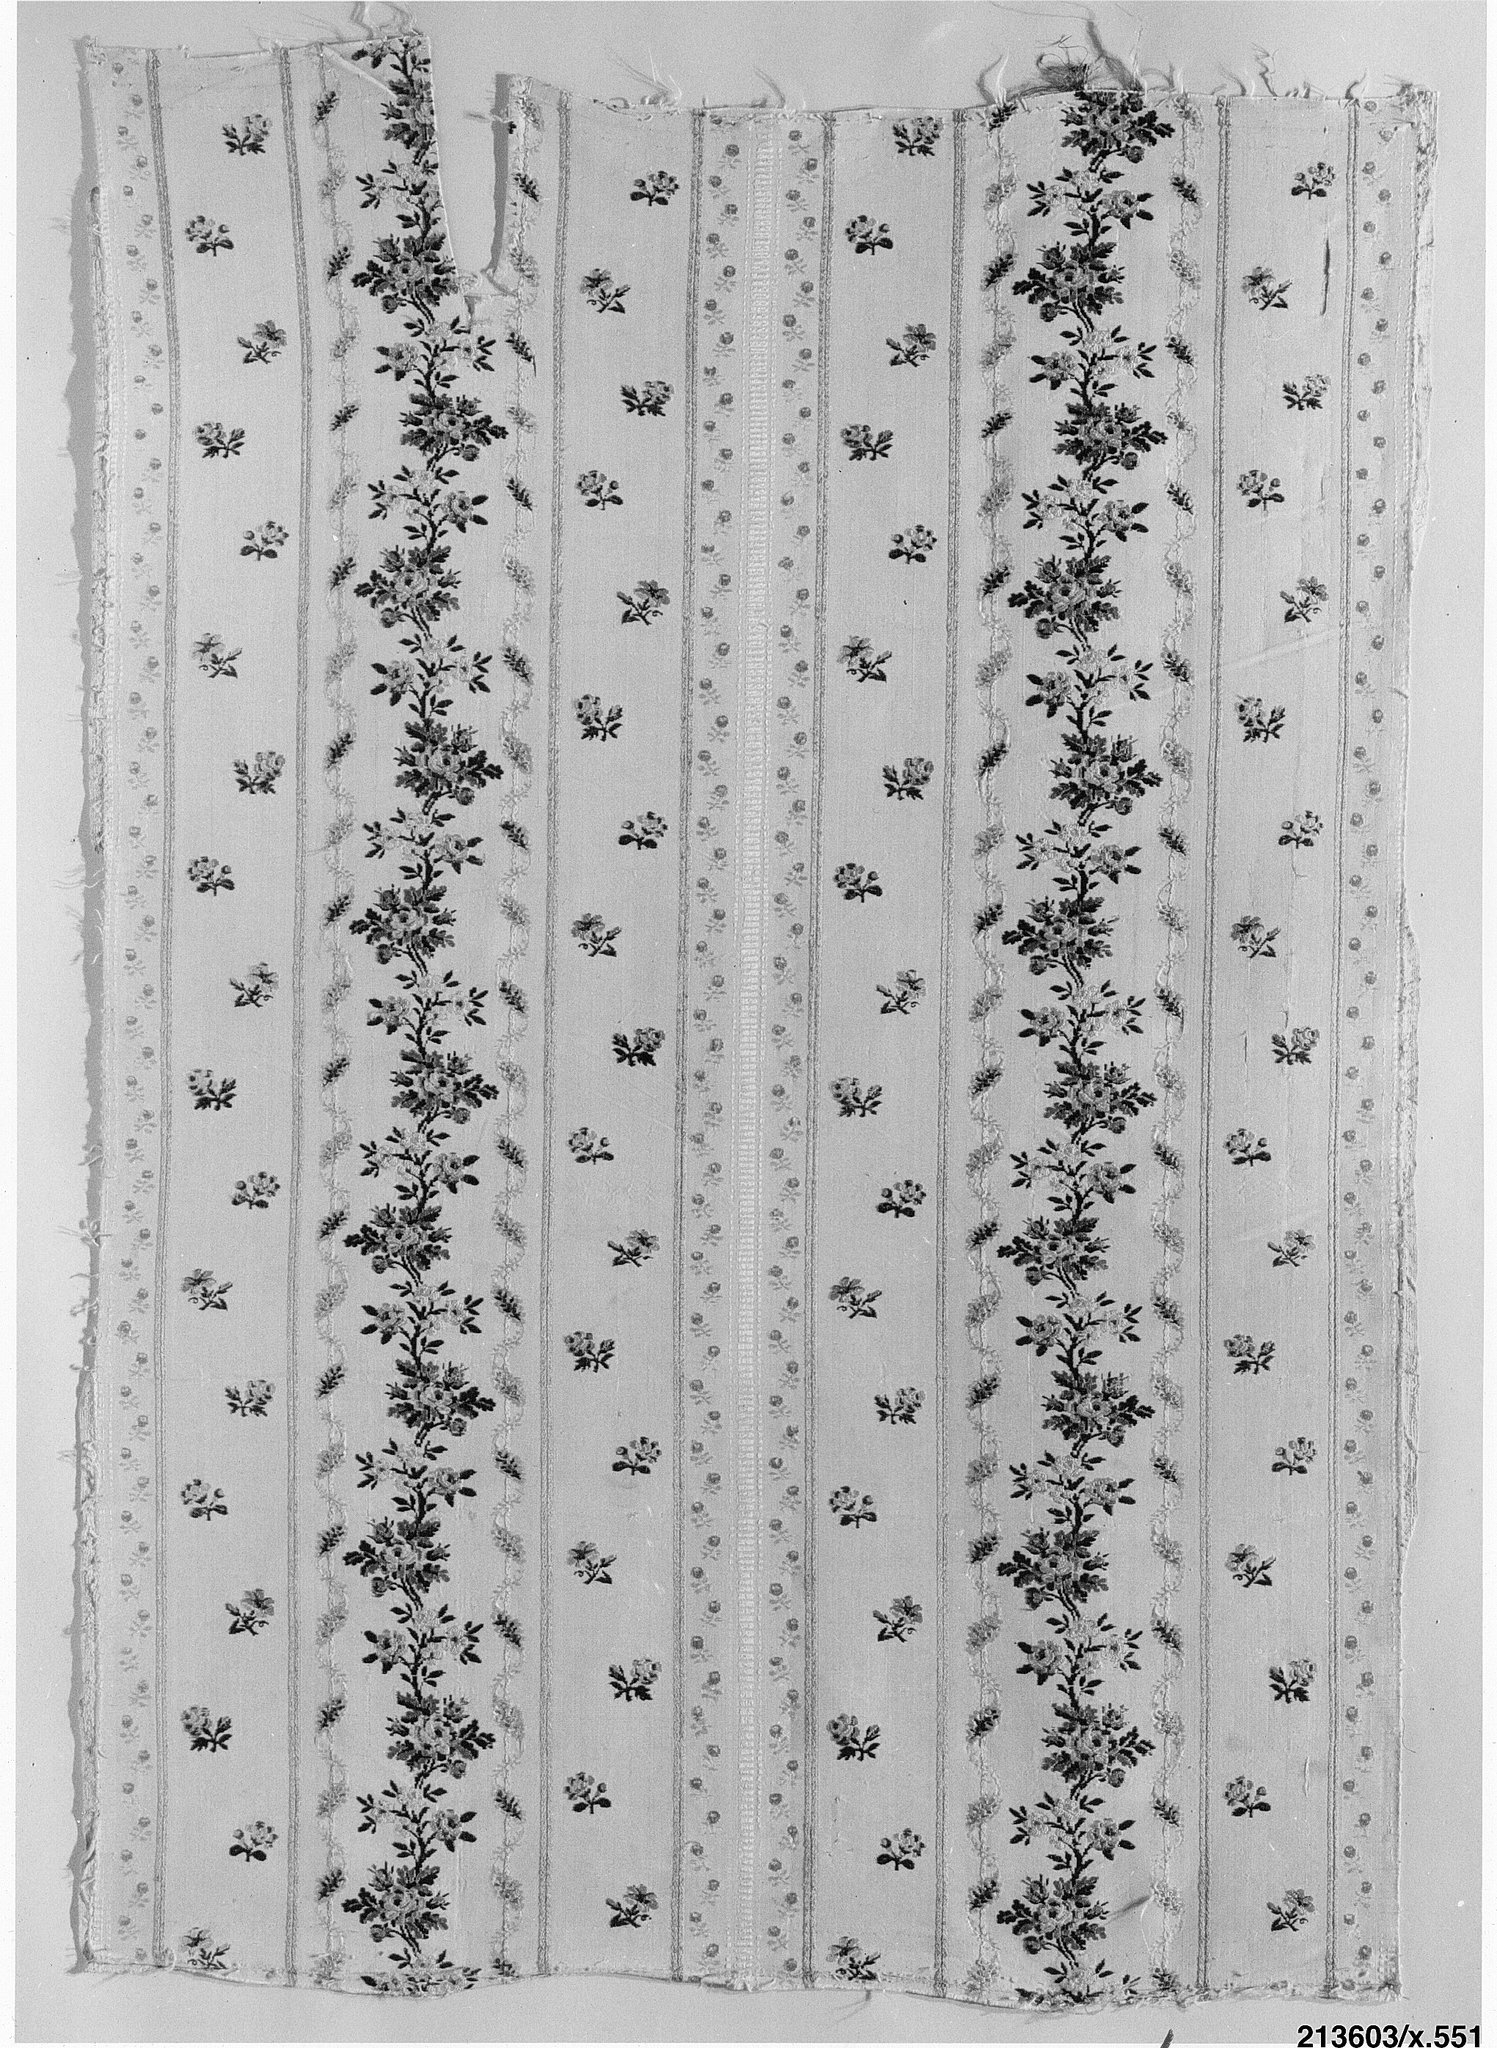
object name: piece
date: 1751-1800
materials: silk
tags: flowers